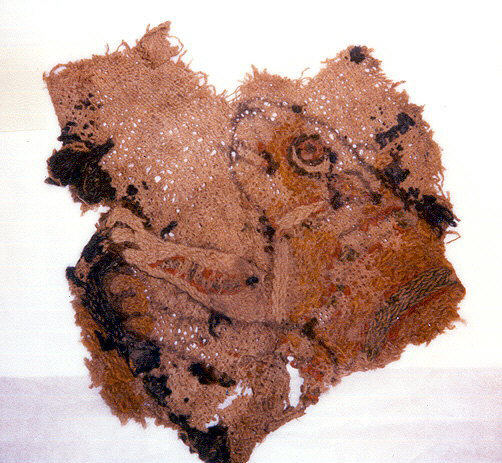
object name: textile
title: Textile fragment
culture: sasanian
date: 501-700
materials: cotton, linen, wool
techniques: embroidery, weave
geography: iran